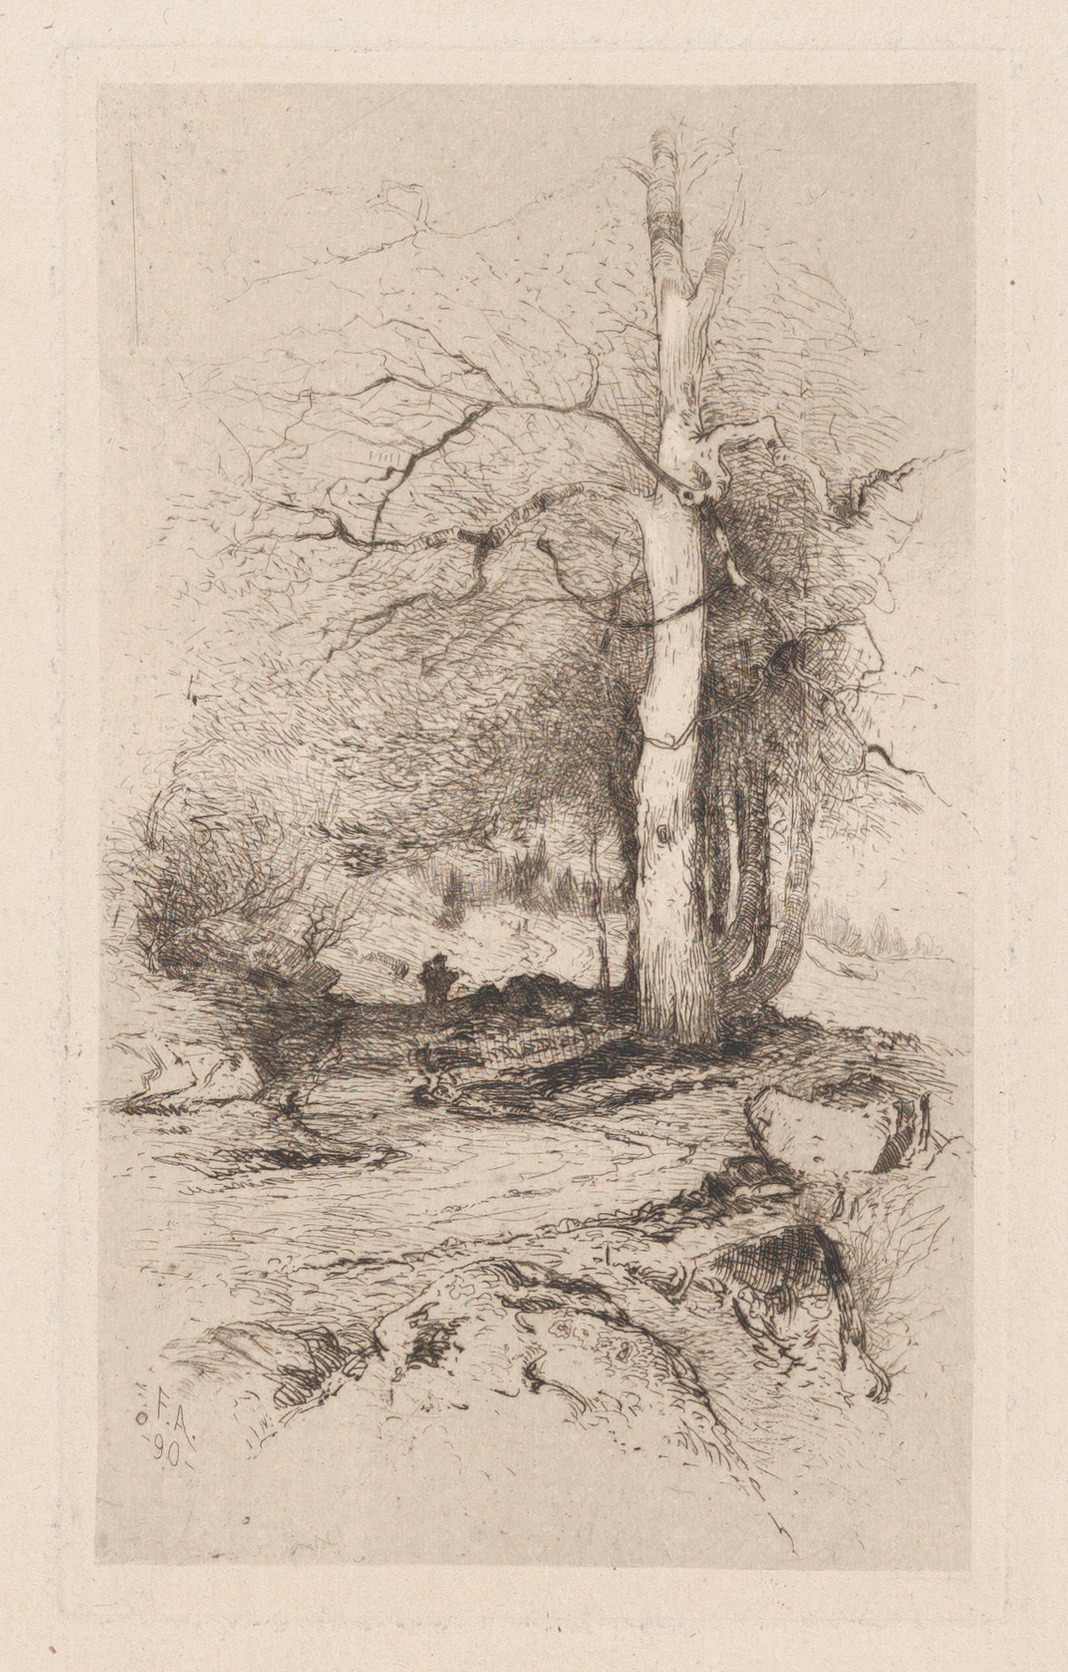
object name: print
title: Landscape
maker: frank anderson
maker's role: artist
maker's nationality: american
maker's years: 1844-1891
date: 1890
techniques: drypoint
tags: landscapes